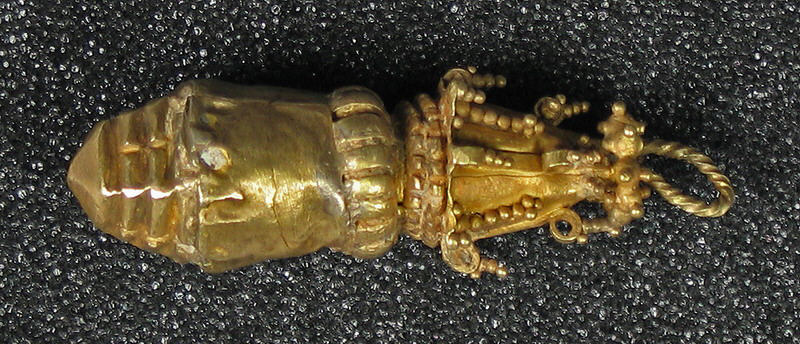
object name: pendant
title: Pendant, Lozenge with Foliate Decoration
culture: indonesian, central java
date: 701-1200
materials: gold